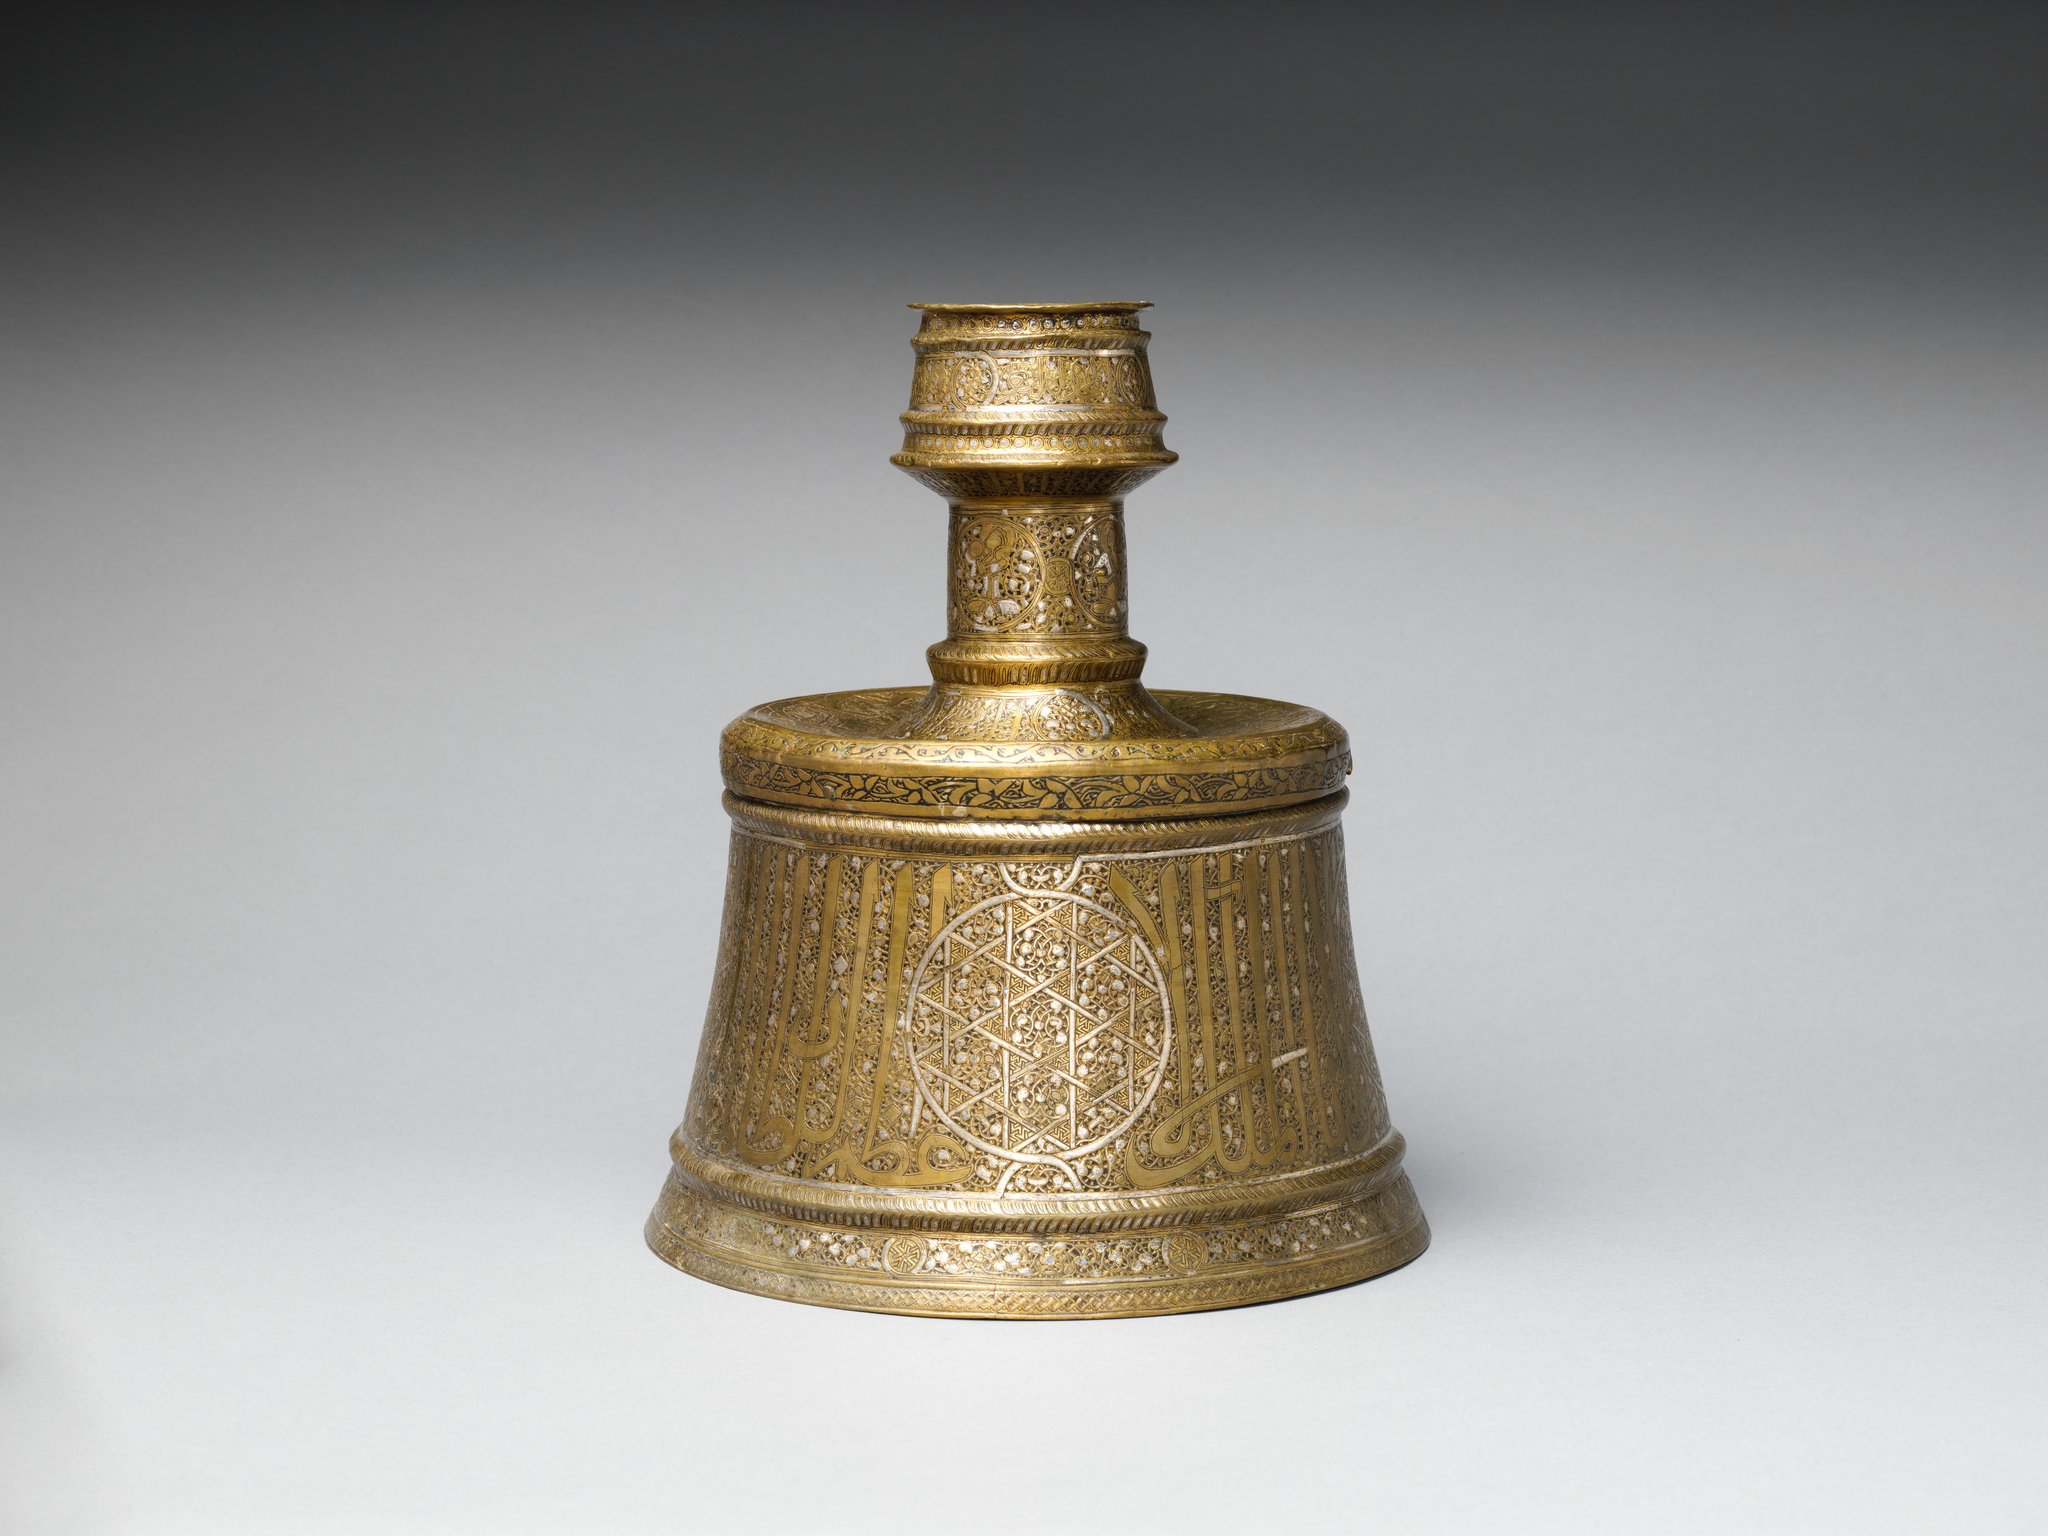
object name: candlestick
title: Candle Stick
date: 1301-1400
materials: brass, silver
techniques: engraving, inlay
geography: iran